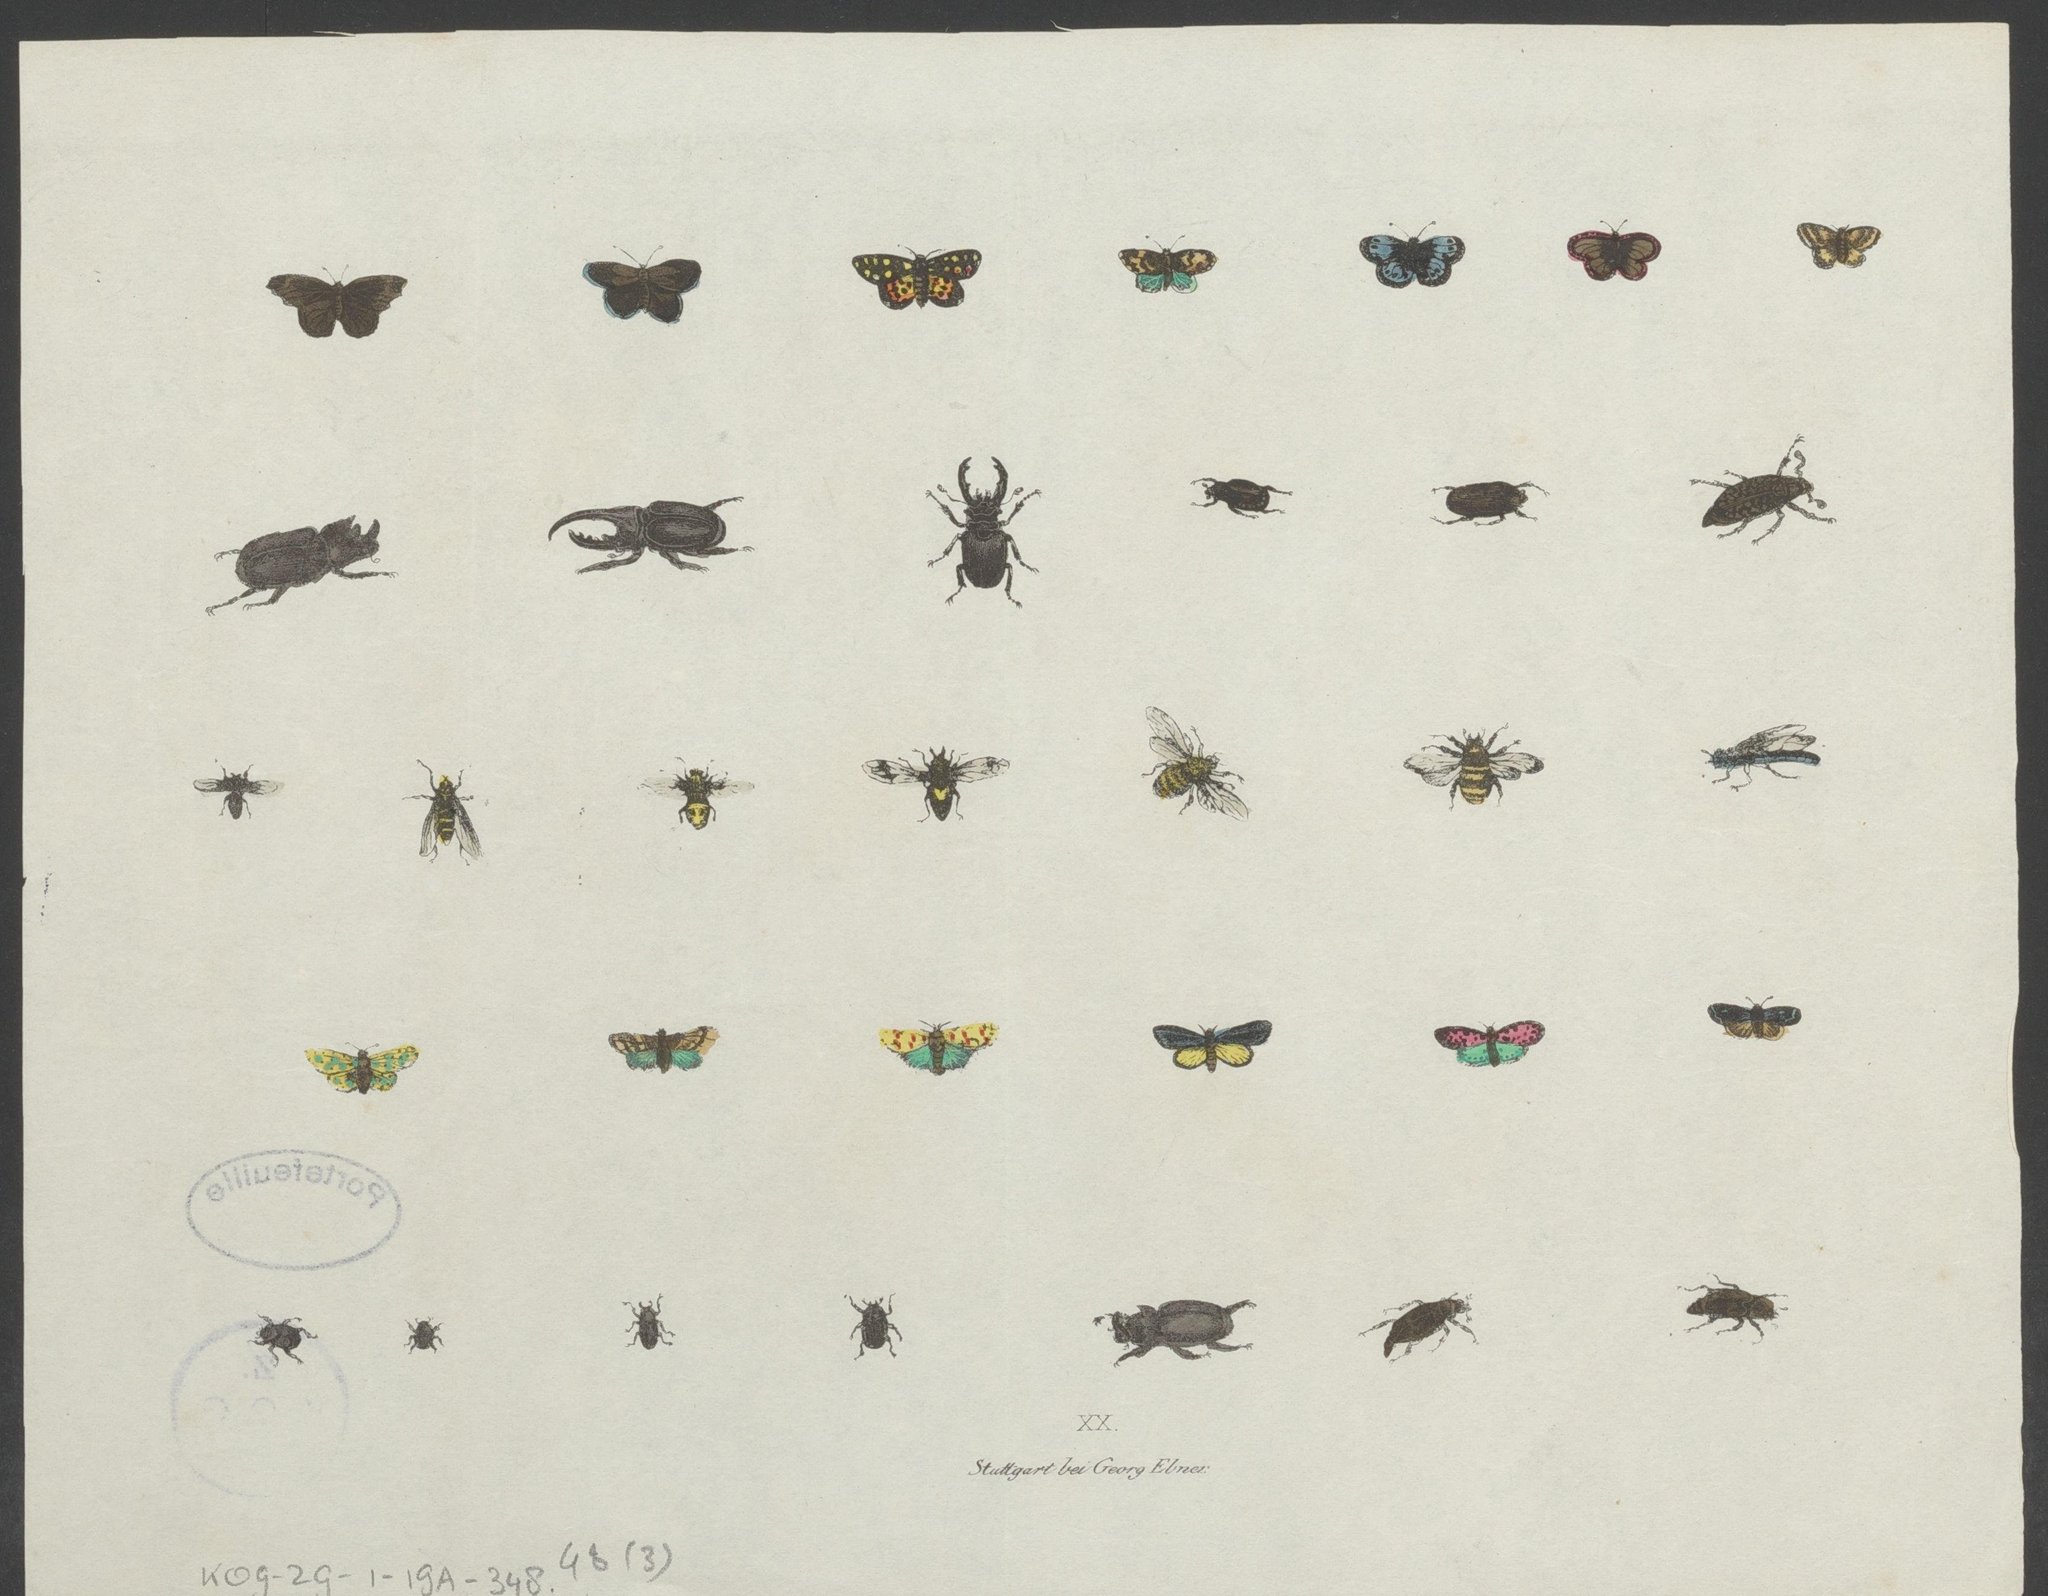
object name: print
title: Vlinders, kevers en bijen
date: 1794-1863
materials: paper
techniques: etching, hand coloring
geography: stuttgart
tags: insects: bee, insects: butterfly, insects: beetle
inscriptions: collector's mark: Lugt 1641, stamp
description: Drieëndertig insecten in vijf rijen. Op de bovenste en vierde rij vlinders. Op de tweede en onderste rij torren en kevers. Op de middelste rij bijen en vliegen. Onderaan genummerd: XX. Onderwerpsrubrieken binnen de Atlas Zeden en Gewoonten: Zeden en Gewoonten in Engeren Zin, Des menschen beging, midden en einde, Kinderleven – Kinderspel en Kinderprenten.